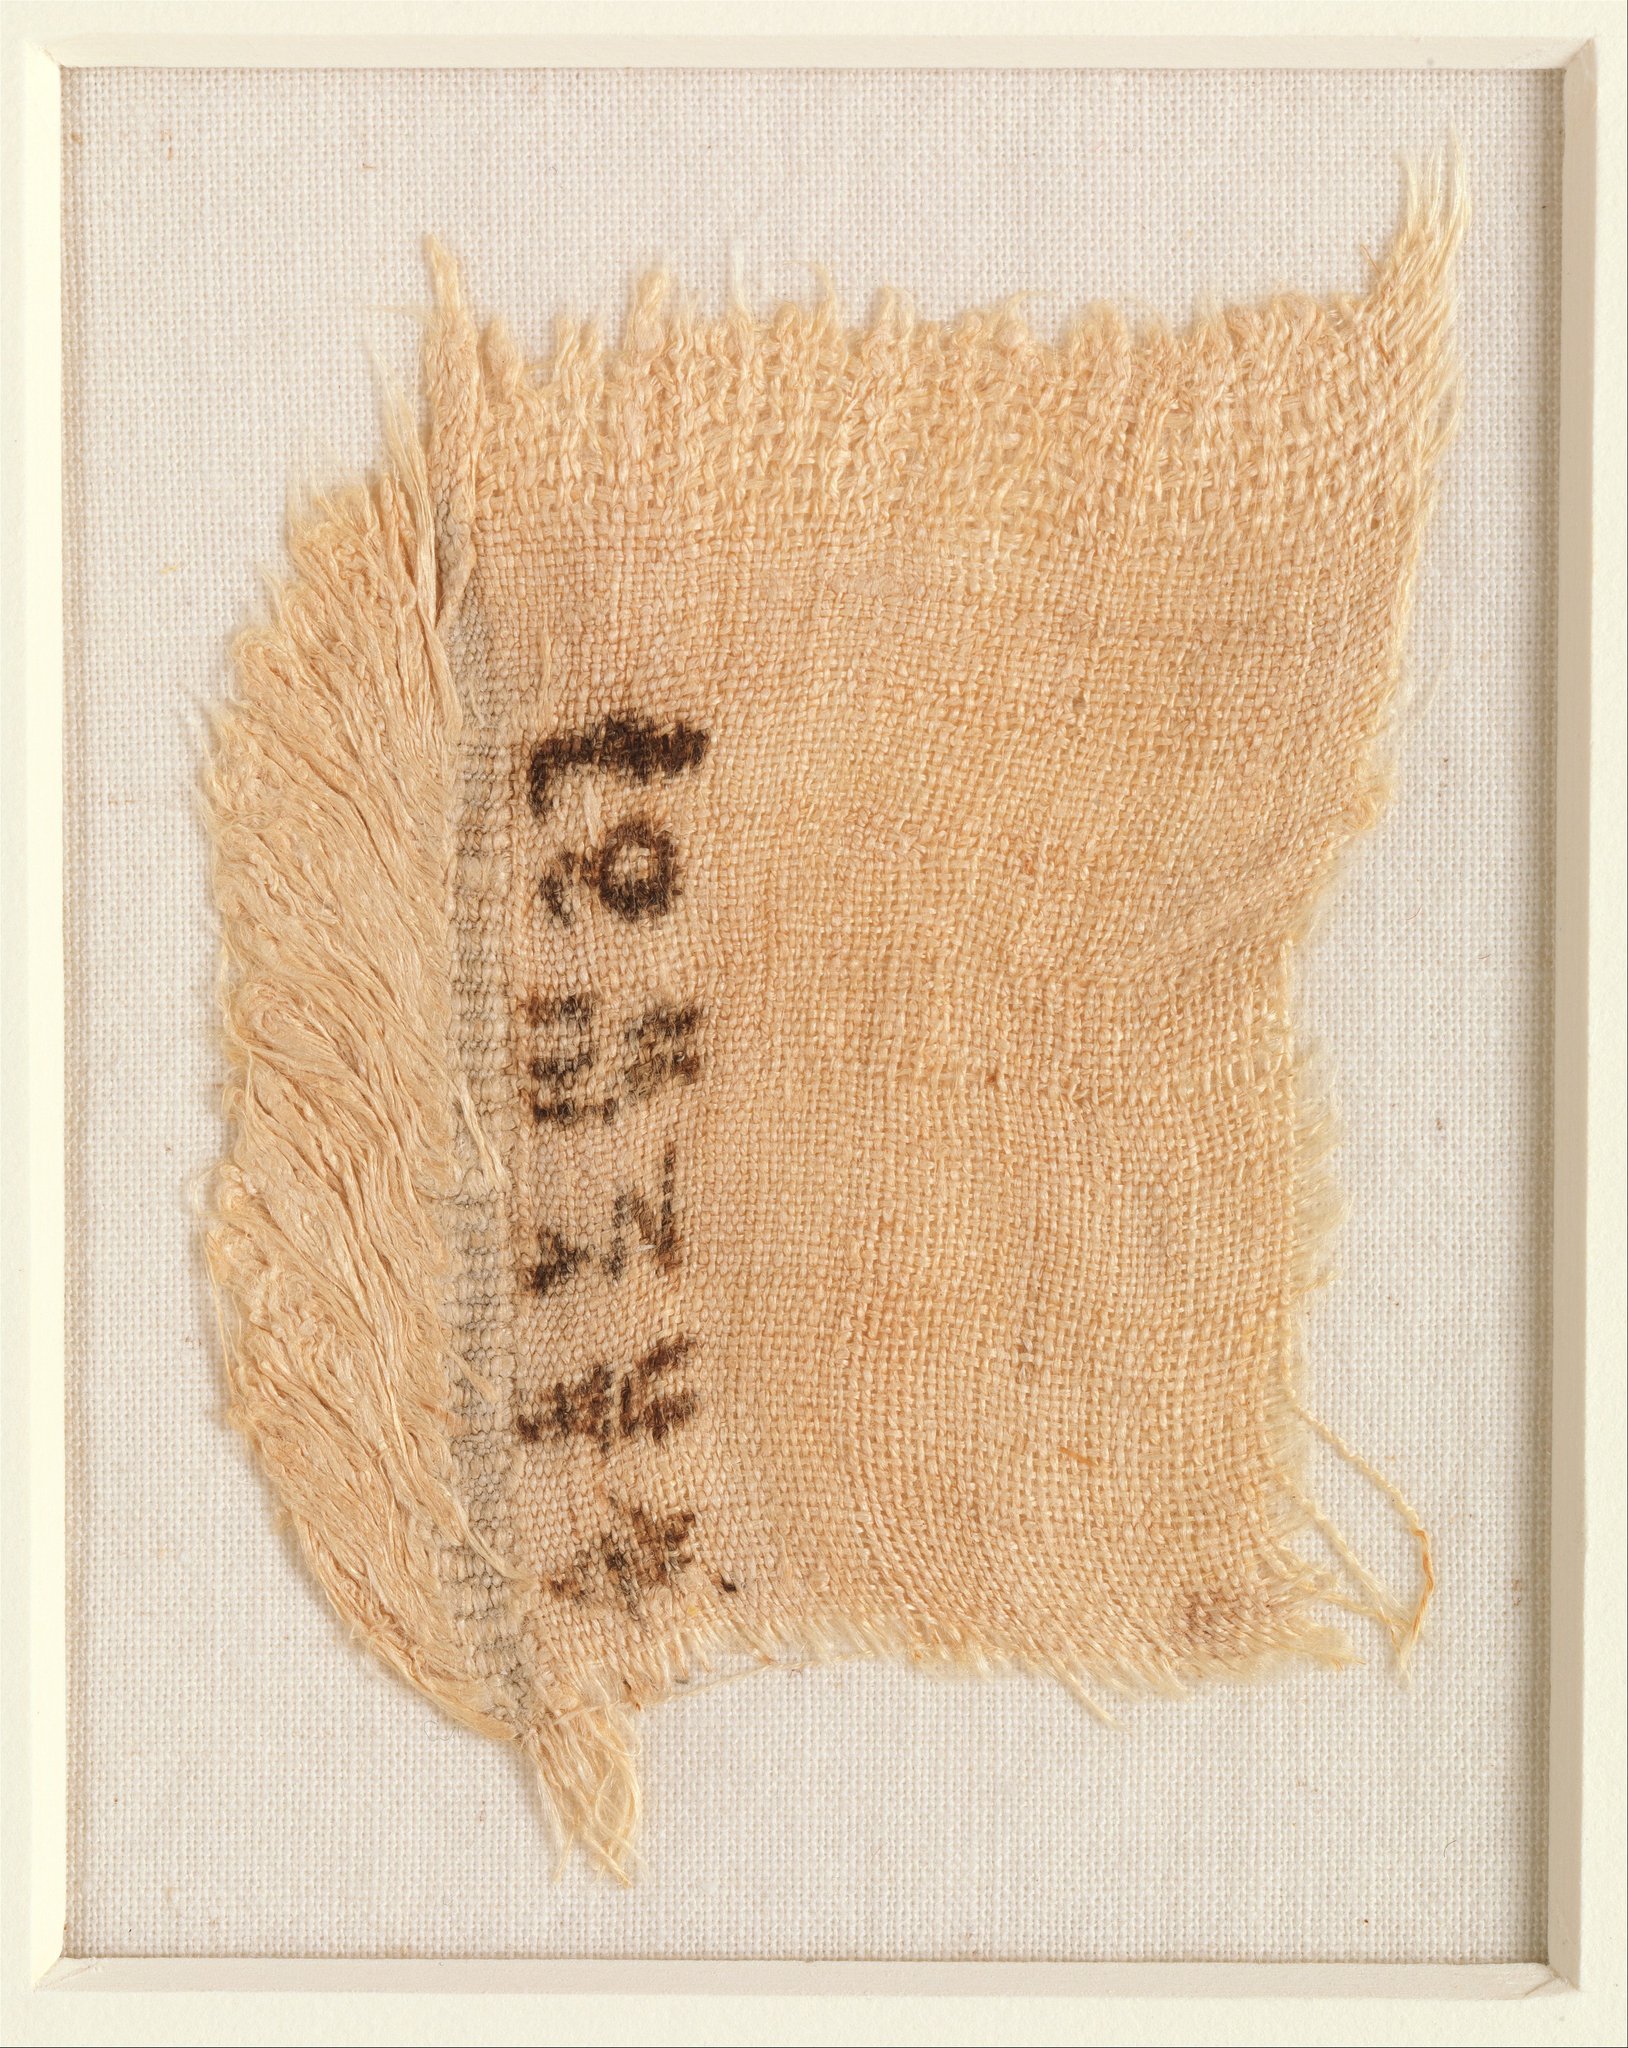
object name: linen mark, wah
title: Linen Mark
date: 1981-1975 BCE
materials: linen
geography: egypt